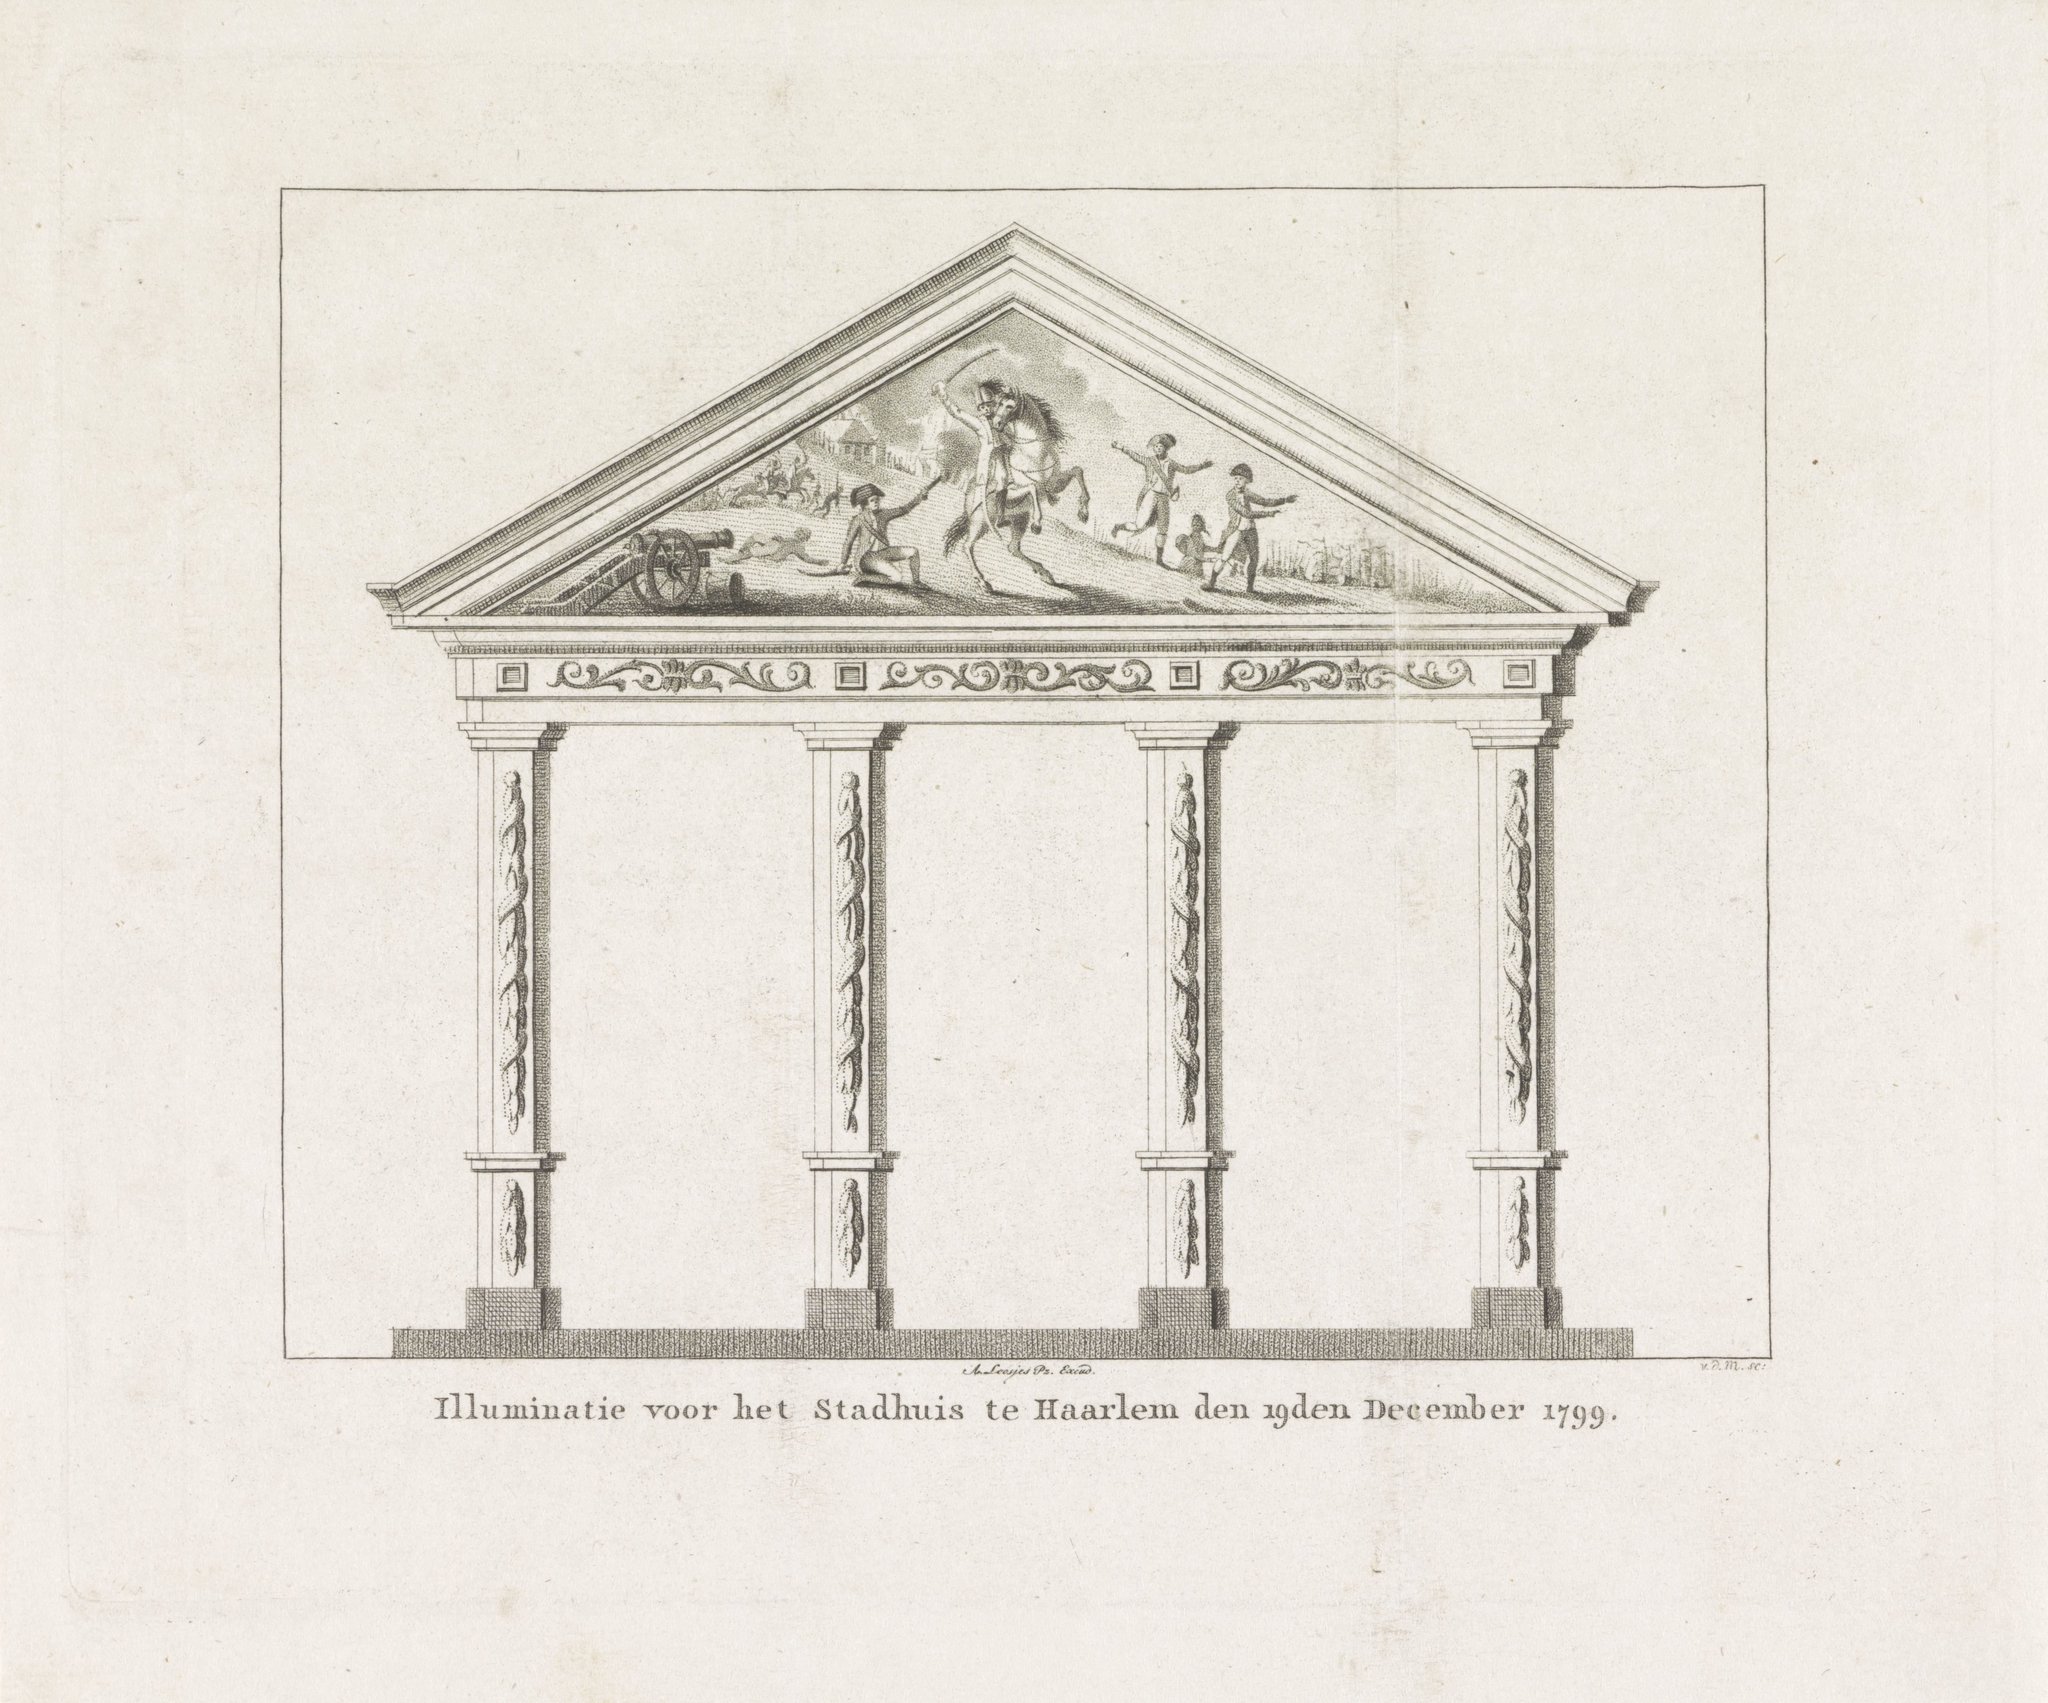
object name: print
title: Illuminatie voor het Stadhuis te Haarlem den 19den December 1799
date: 1801-1803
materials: paper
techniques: engraving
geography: netherlands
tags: bonfire, fire-works (+ illumination, fire-works ~ festive activities)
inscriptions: collector's mark: Lugt 2228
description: De plaat is gesigneerd "v.d.M.", dit is hier geïnterpreteerd als Noach van der Meer (II). Gebruikt als illustratie in: Adriaan Loosjes Pz., Geschiedkundig gedenkstuk van het voorgevallene binnen Haarlem in de laatste helft van het jaar 1799. Haarlem: Adriaan Loosjes Pz., 1803.